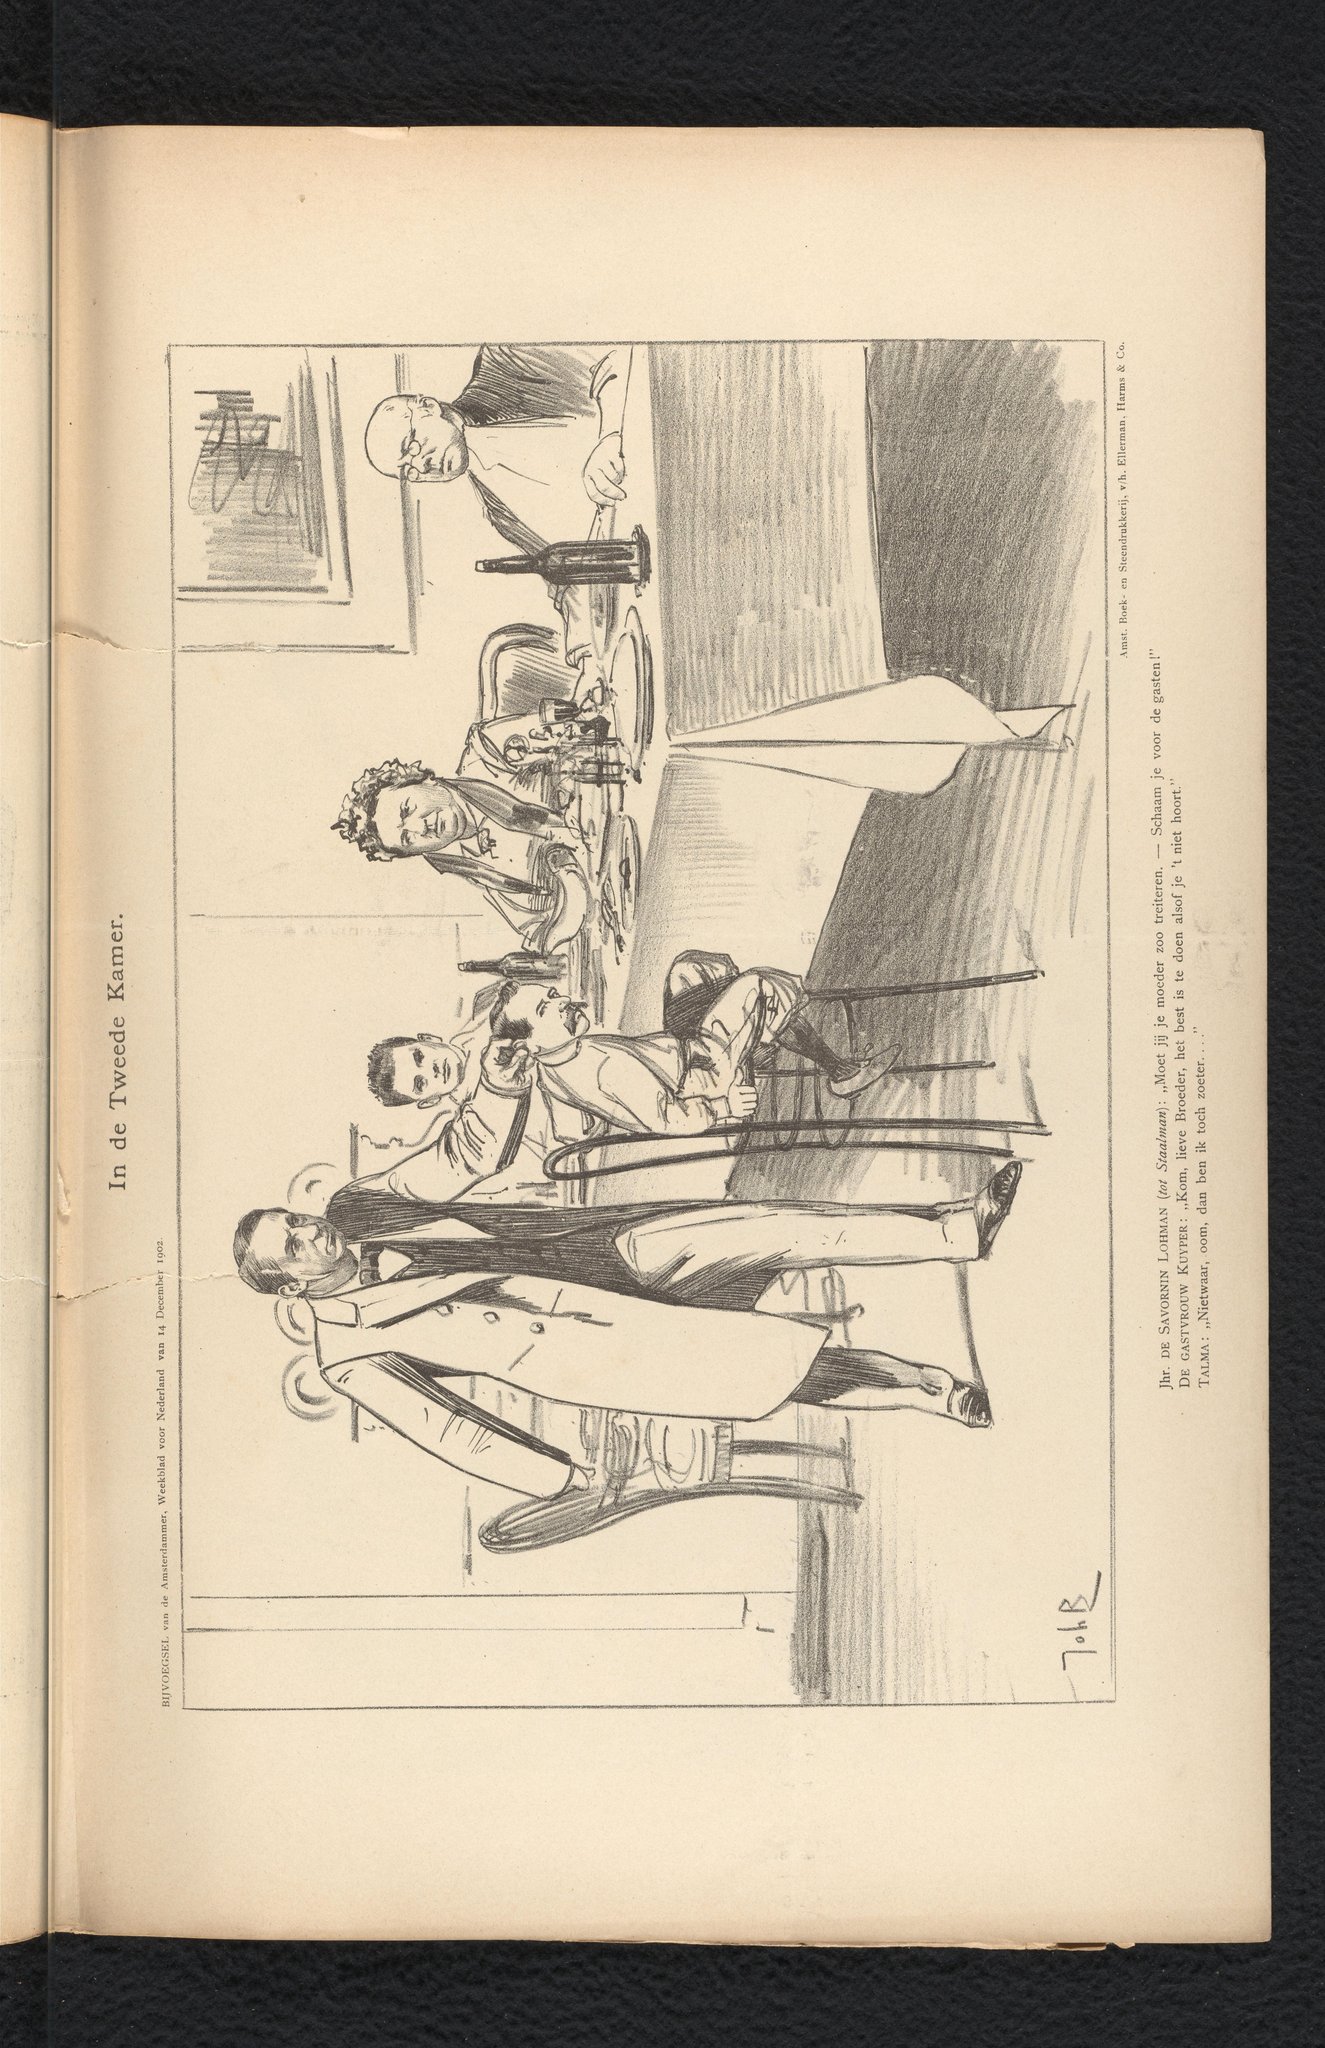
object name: cartoon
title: In de Tweede Kamer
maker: johan braakensiek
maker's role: draughtsman, print maker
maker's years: 1858-1940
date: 1902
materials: paper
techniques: lithograph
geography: amsterdam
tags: politician, the hague, jonkheer alexander frederik de savornin lohman, abraham kuyper, rome, priest, herman johannes aloysius maria schaepman, pulling the ears (of naughty children), the good child versus the naughty child, (family) meal, political caricatures and satires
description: Familiediner waarbij jhr. De Savornin Lohman het ondeugende kind Andries Staalman bij het oor grijpt. Verder aan tafel gastvrouw Abraham Kuyper, Herman Schaepman en oudere zoontje Syb Talma.